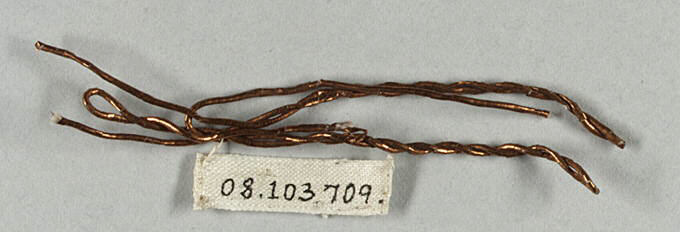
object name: thread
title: Tinsel and metal thread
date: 1601-1800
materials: metal thread